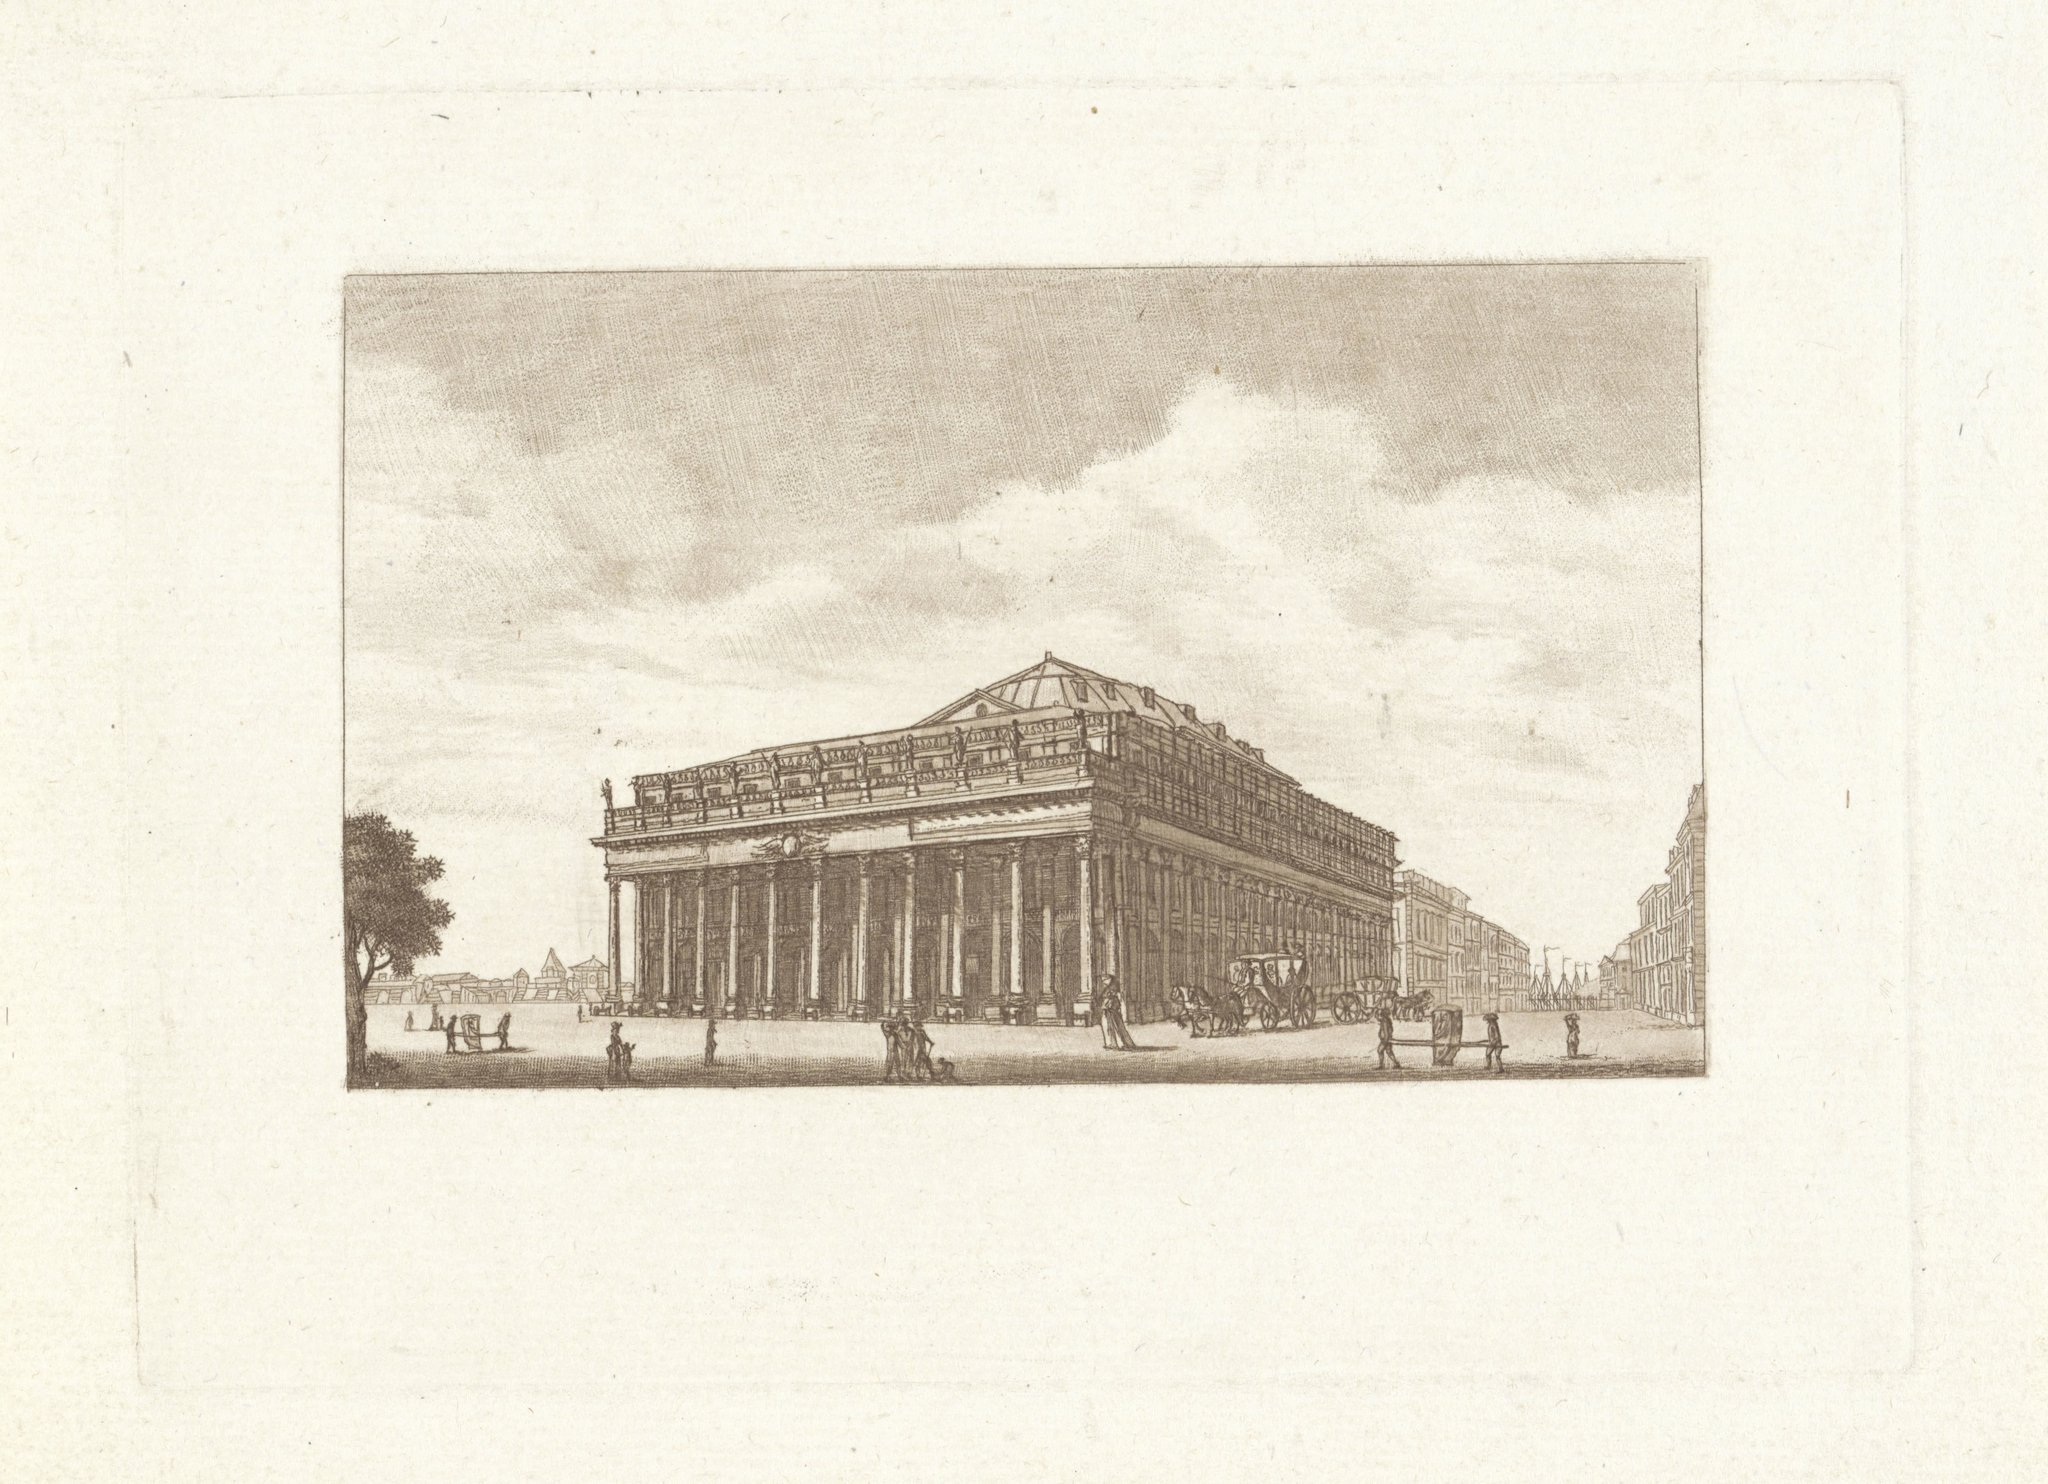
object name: print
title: Schouwburg van Bordeaux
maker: hendrik schwegman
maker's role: draughtsman, print maker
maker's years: 1761-1816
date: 1771-1816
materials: paper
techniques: etching, roulette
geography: haarlem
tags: theatre (building)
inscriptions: collector's mark: Lugt 2228